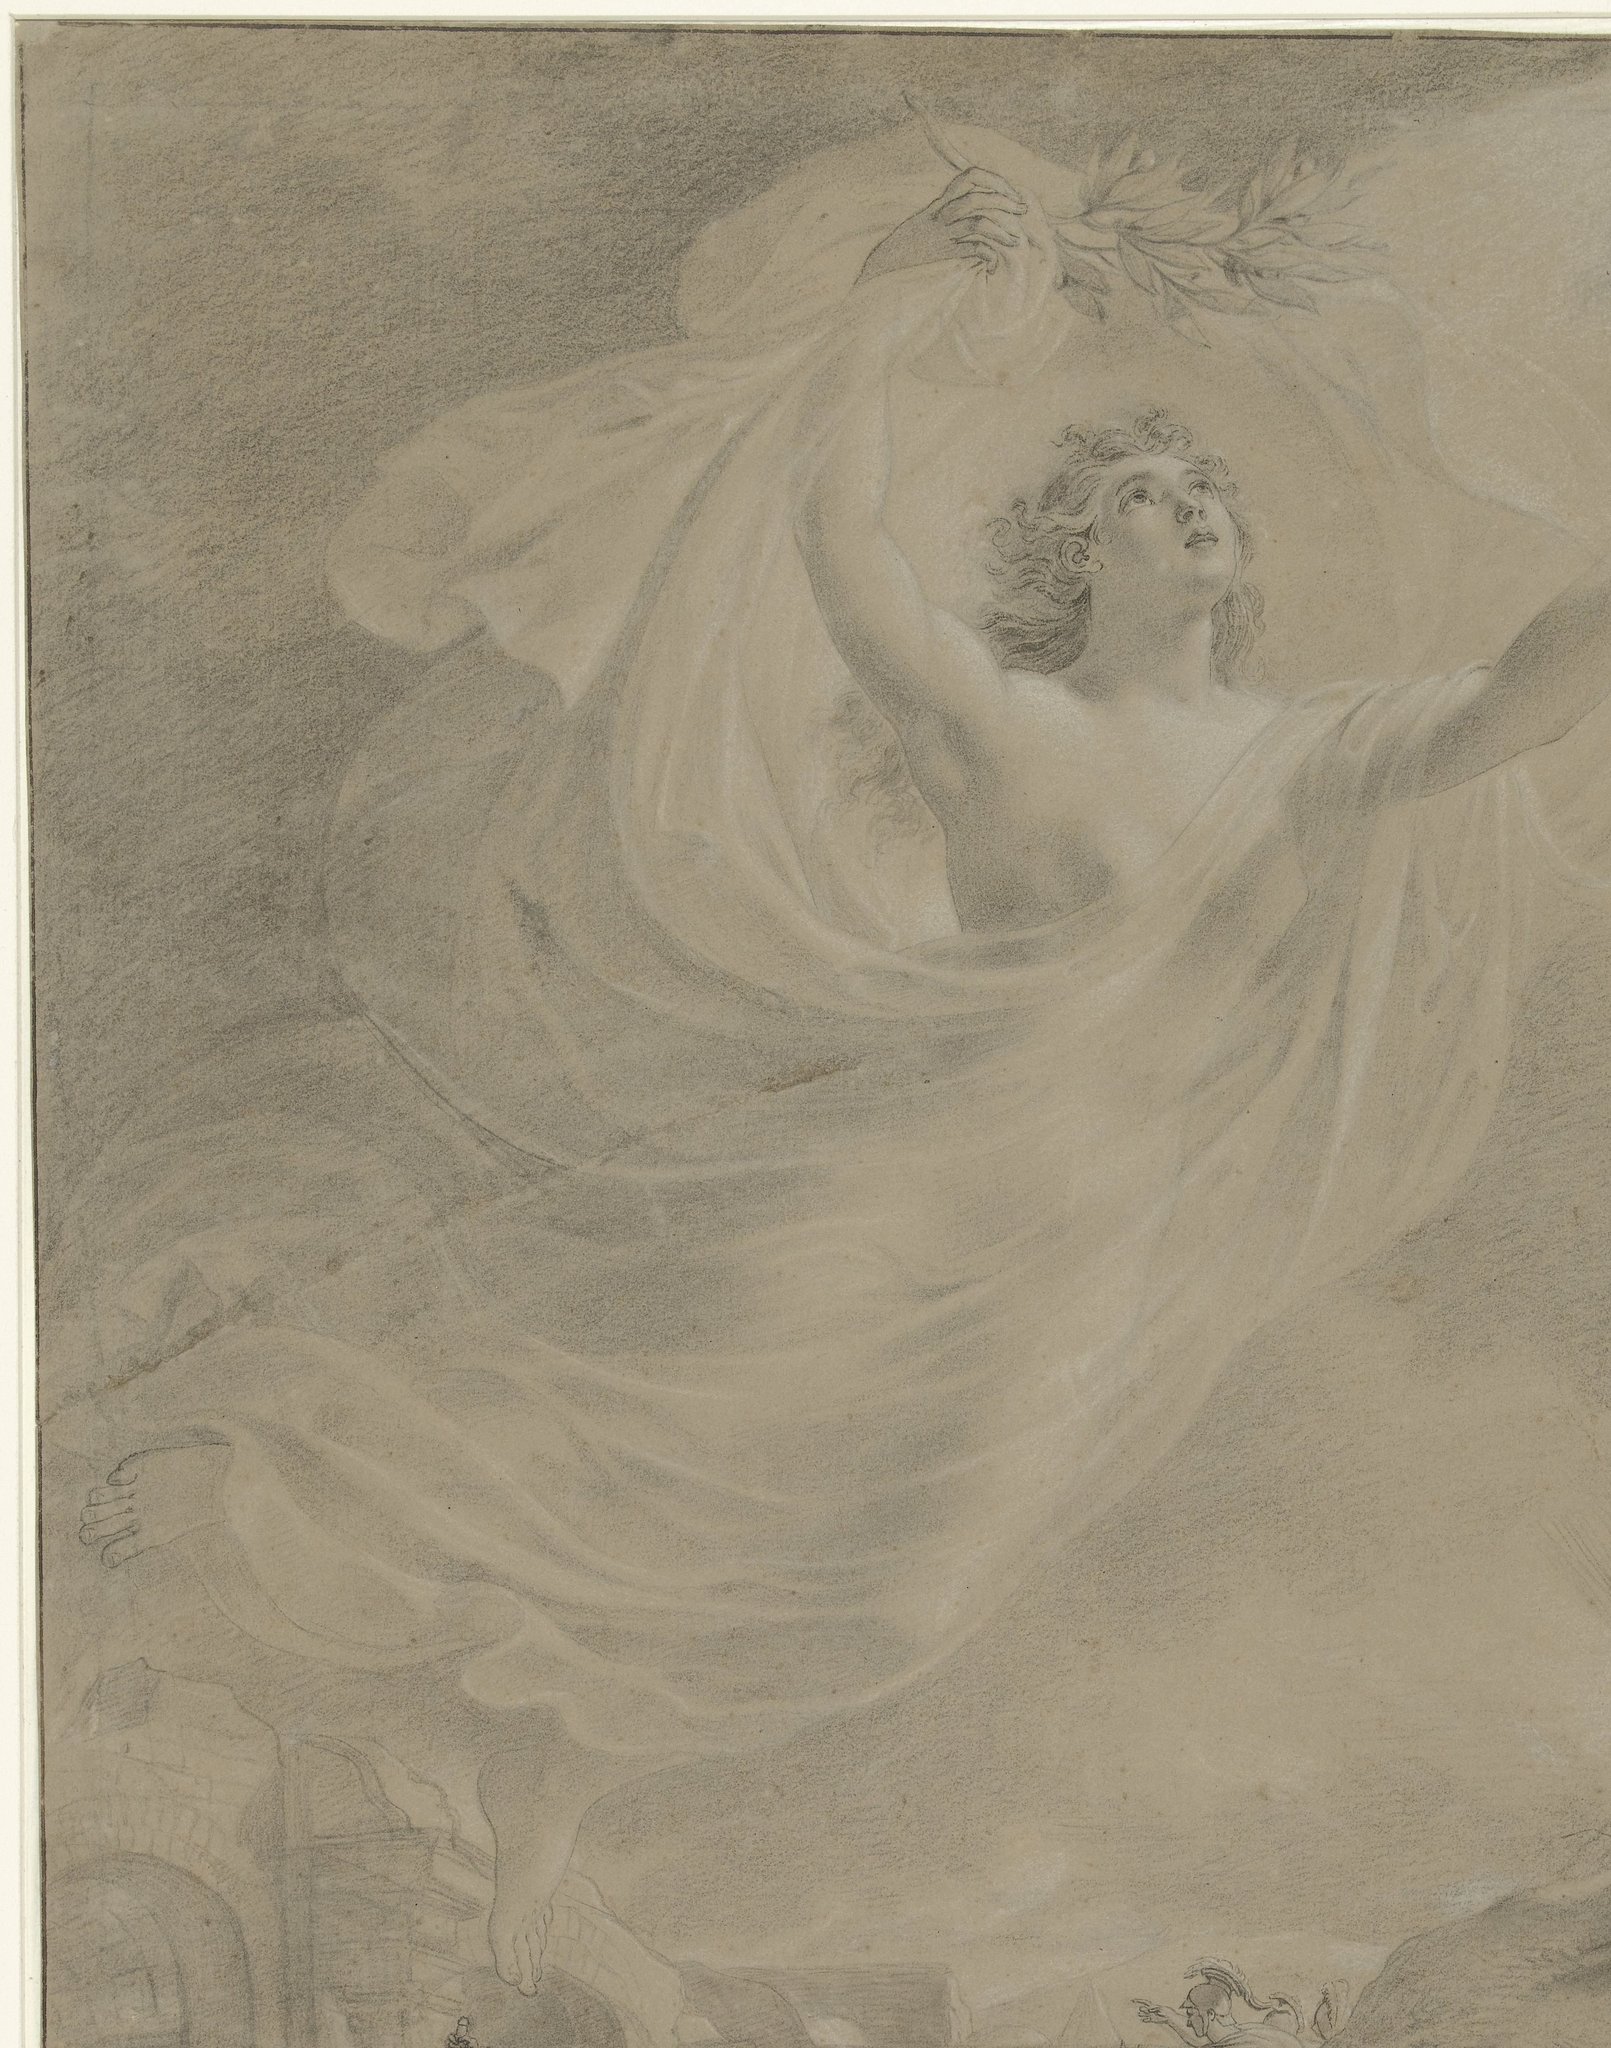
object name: design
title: Allegorie op de Vrede van Amiens 1802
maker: jacques kuyper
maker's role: draughtsman, print maker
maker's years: 1761-1808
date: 1802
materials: chalk, ink, paper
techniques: pen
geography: netherlands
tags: symbols, allegories of peace, 'pax'; 'pace' (ripa)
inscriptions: inscription: ‘Dessin pour la Gravure / J: Kuyper’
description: Allegorie op de Vrede van Amiens, op 27 maart 1802, die een einde maakte aan de oorlog tussen Groot-Brittannië en de Franse republiek, Spanje en de Bataafse Republiek. Centraal zweeft de Vrede over de wereld waar nog oorlog heerst. Zij heeft een olijftak in de hand en kijkt met een smekende blik naar de hemel. Onderaan oorlog en moord, rechts schuilt een gezin voor het geweld.